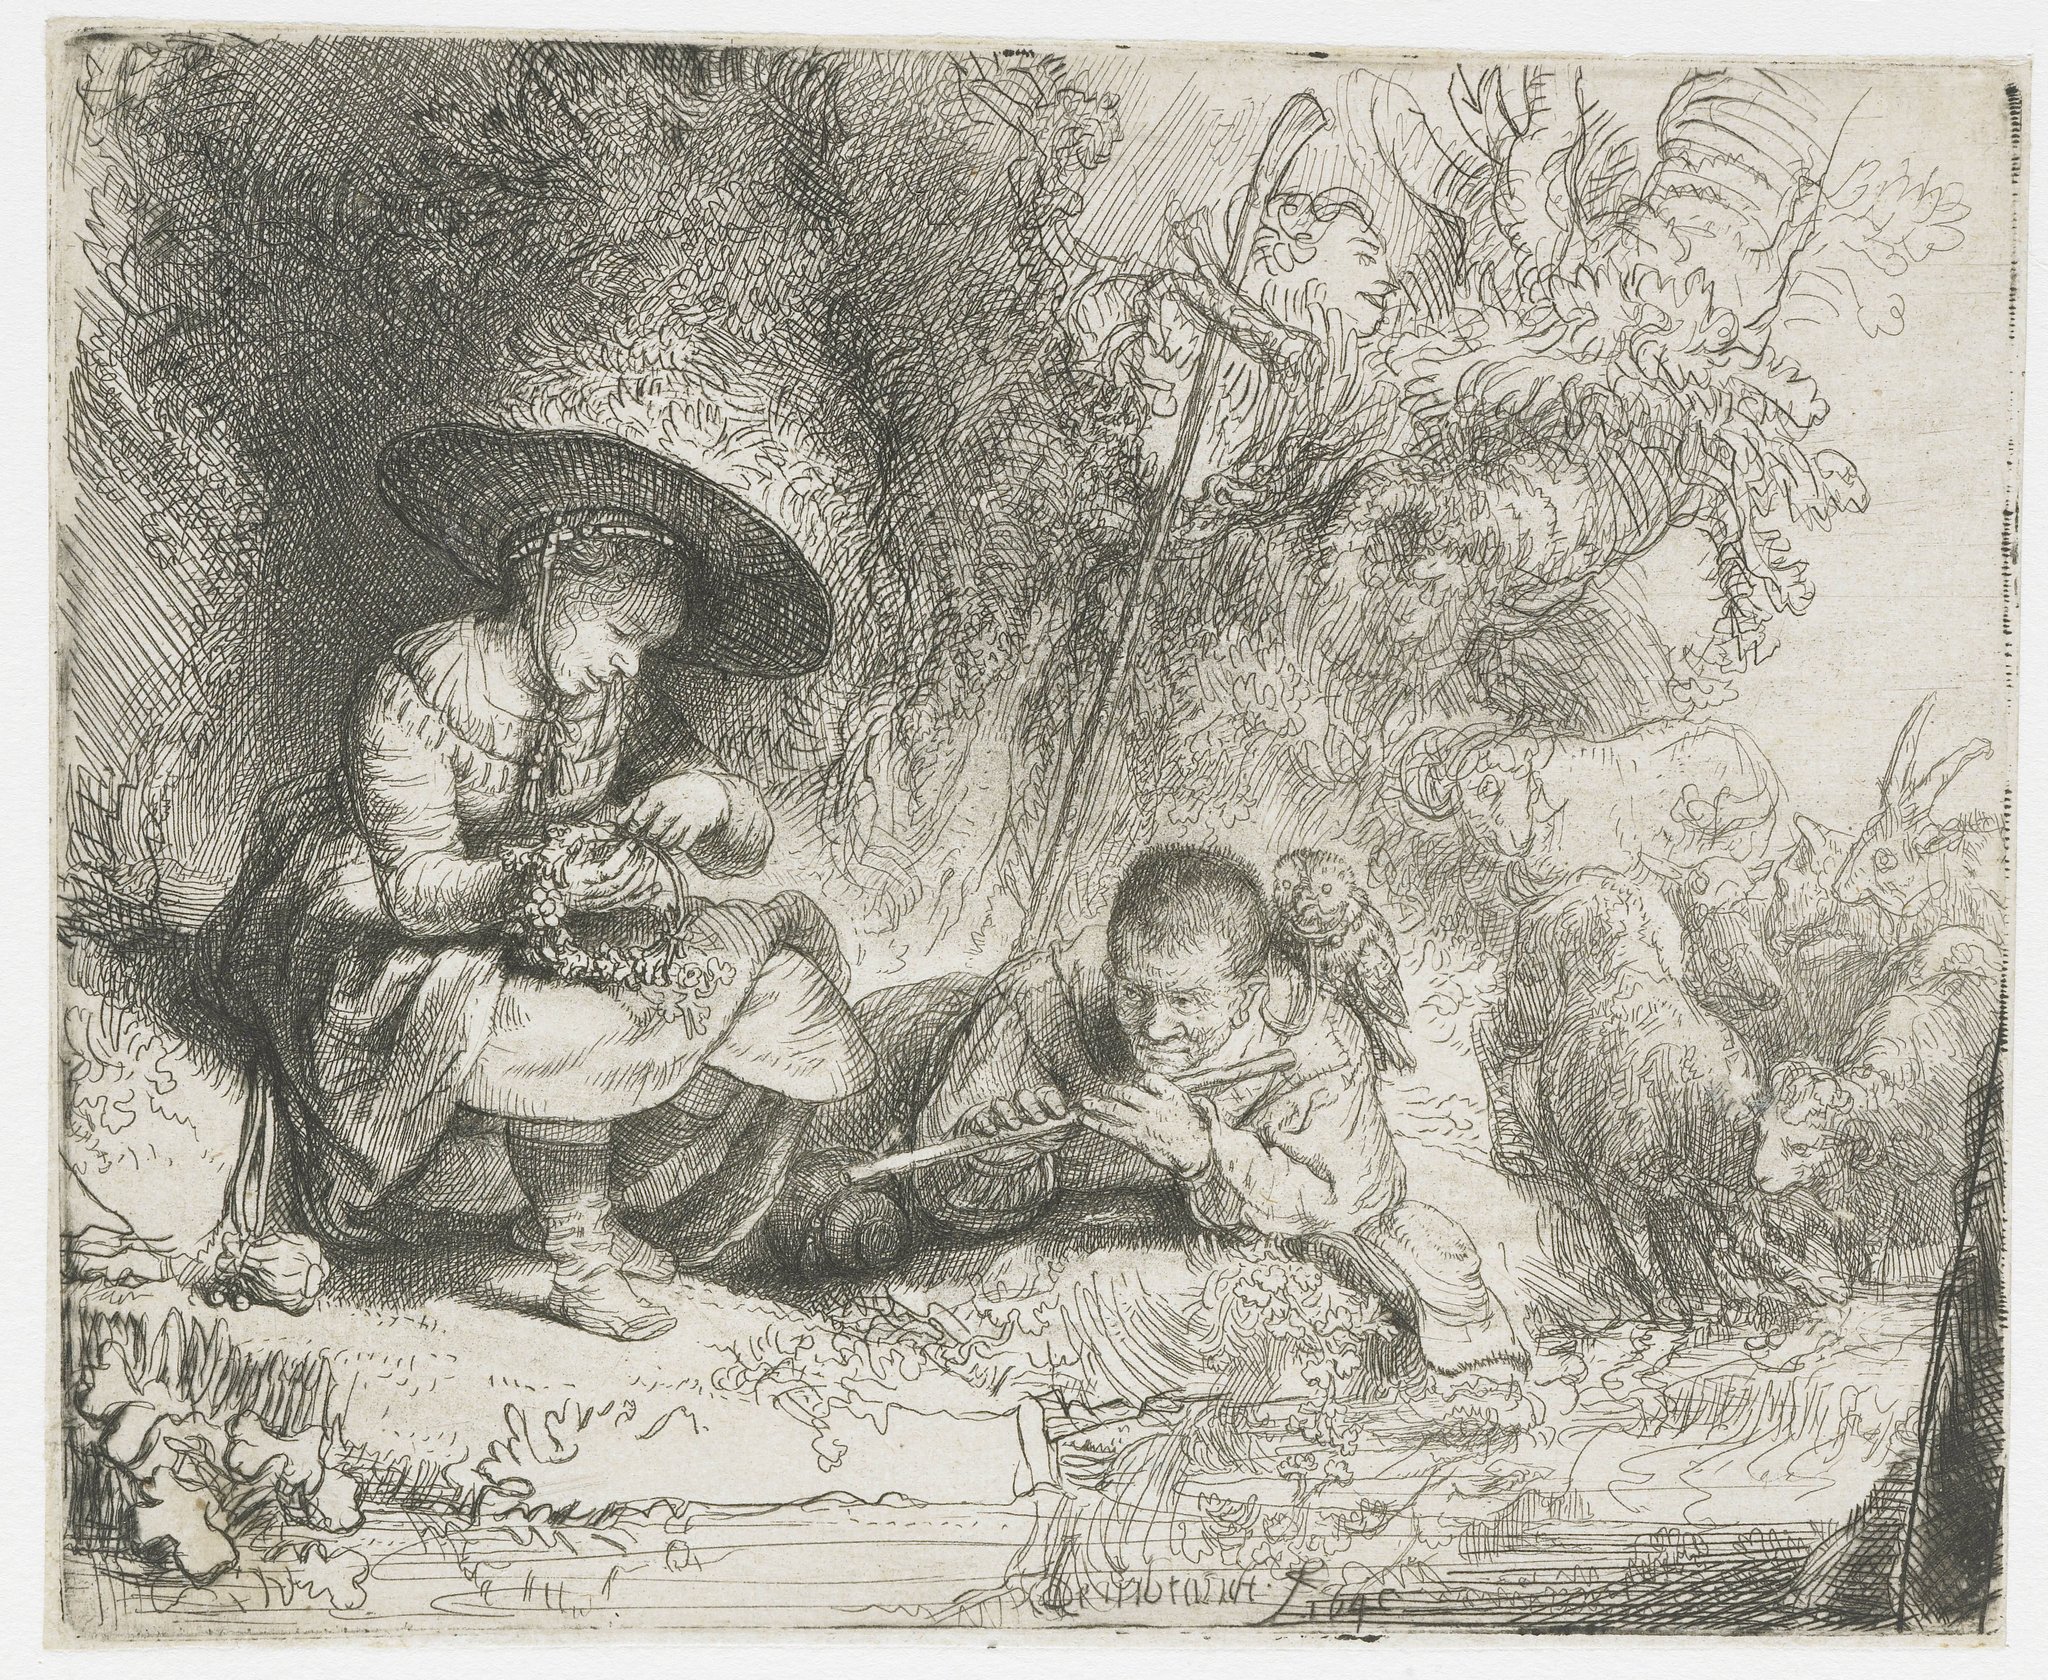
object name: print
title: The flute player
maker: rembrandt van rijn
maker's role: draughtsman, painter, print maker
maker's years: 1606-1669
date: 1642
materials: paper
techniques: drypoint, etching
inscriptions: mark: 669 a, signature and date: ‘Rembrandt f. 1642’ Lugt, mark: Lugt 2228